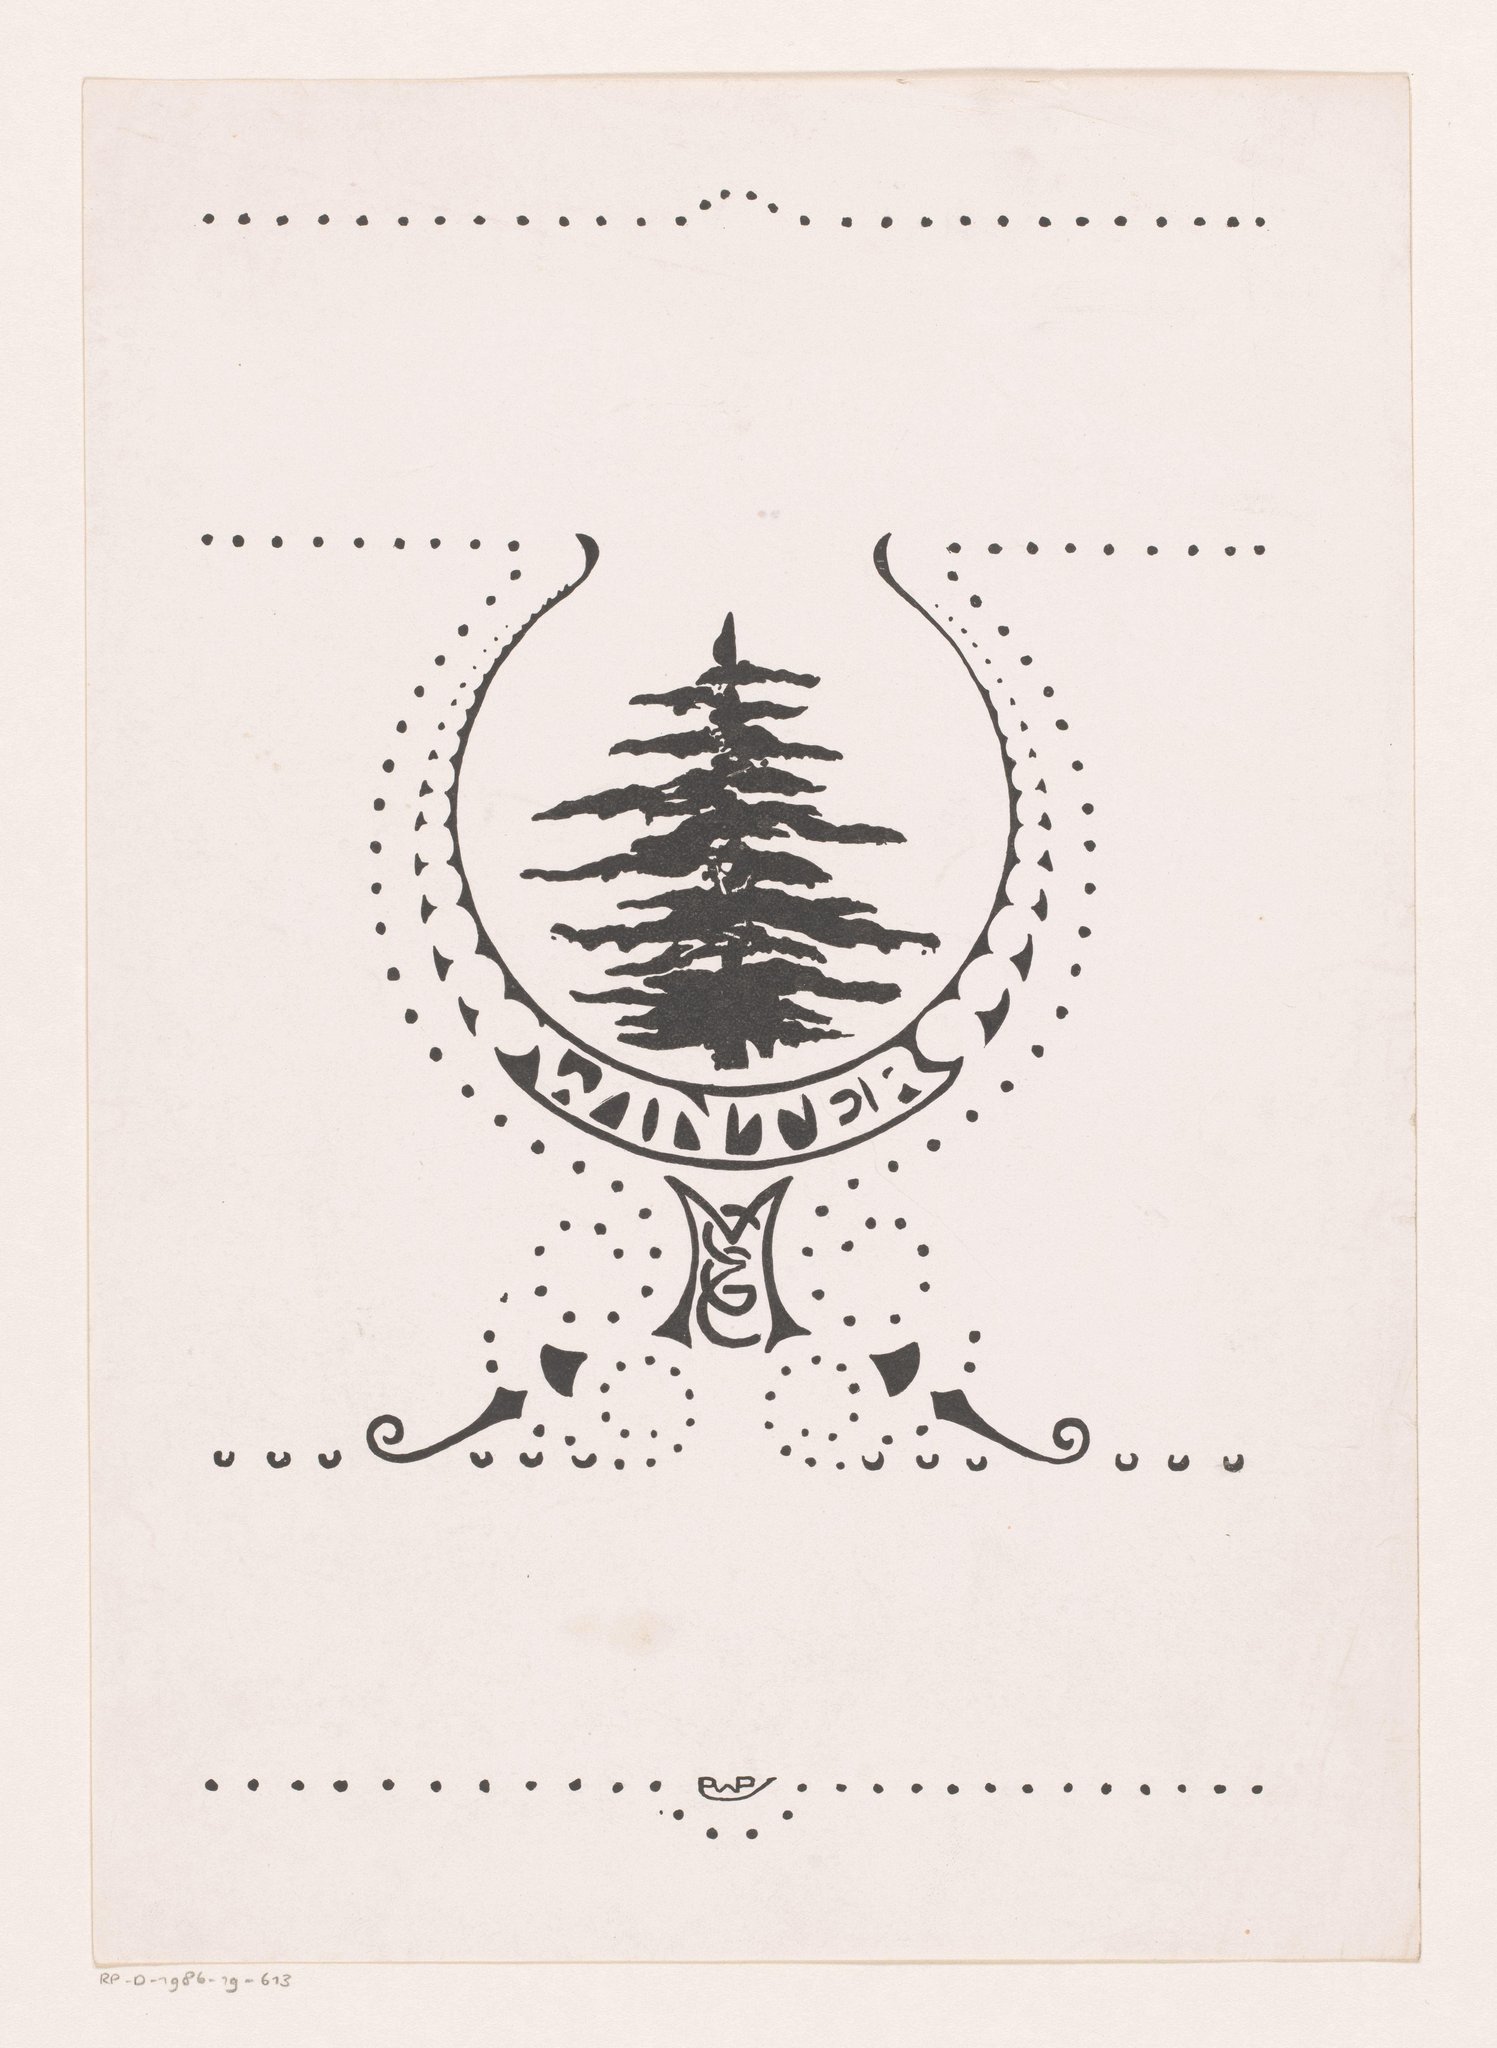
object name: photomechanical print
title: Omslagontwerp voor: Cornelis Veth, Sport en spel in de kunst (Winter), 1916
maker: reinier willem petrus de vries (1874-1953)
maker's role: draughtsman, print maker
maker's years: 1874-1953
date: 1916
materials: paper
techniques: printing block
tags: snow, trees: pine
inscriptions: collector's mark: ‘R:MVS.’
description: Ontwerp met een besneeuwde dennenboom in een cirkel en ornamenten.